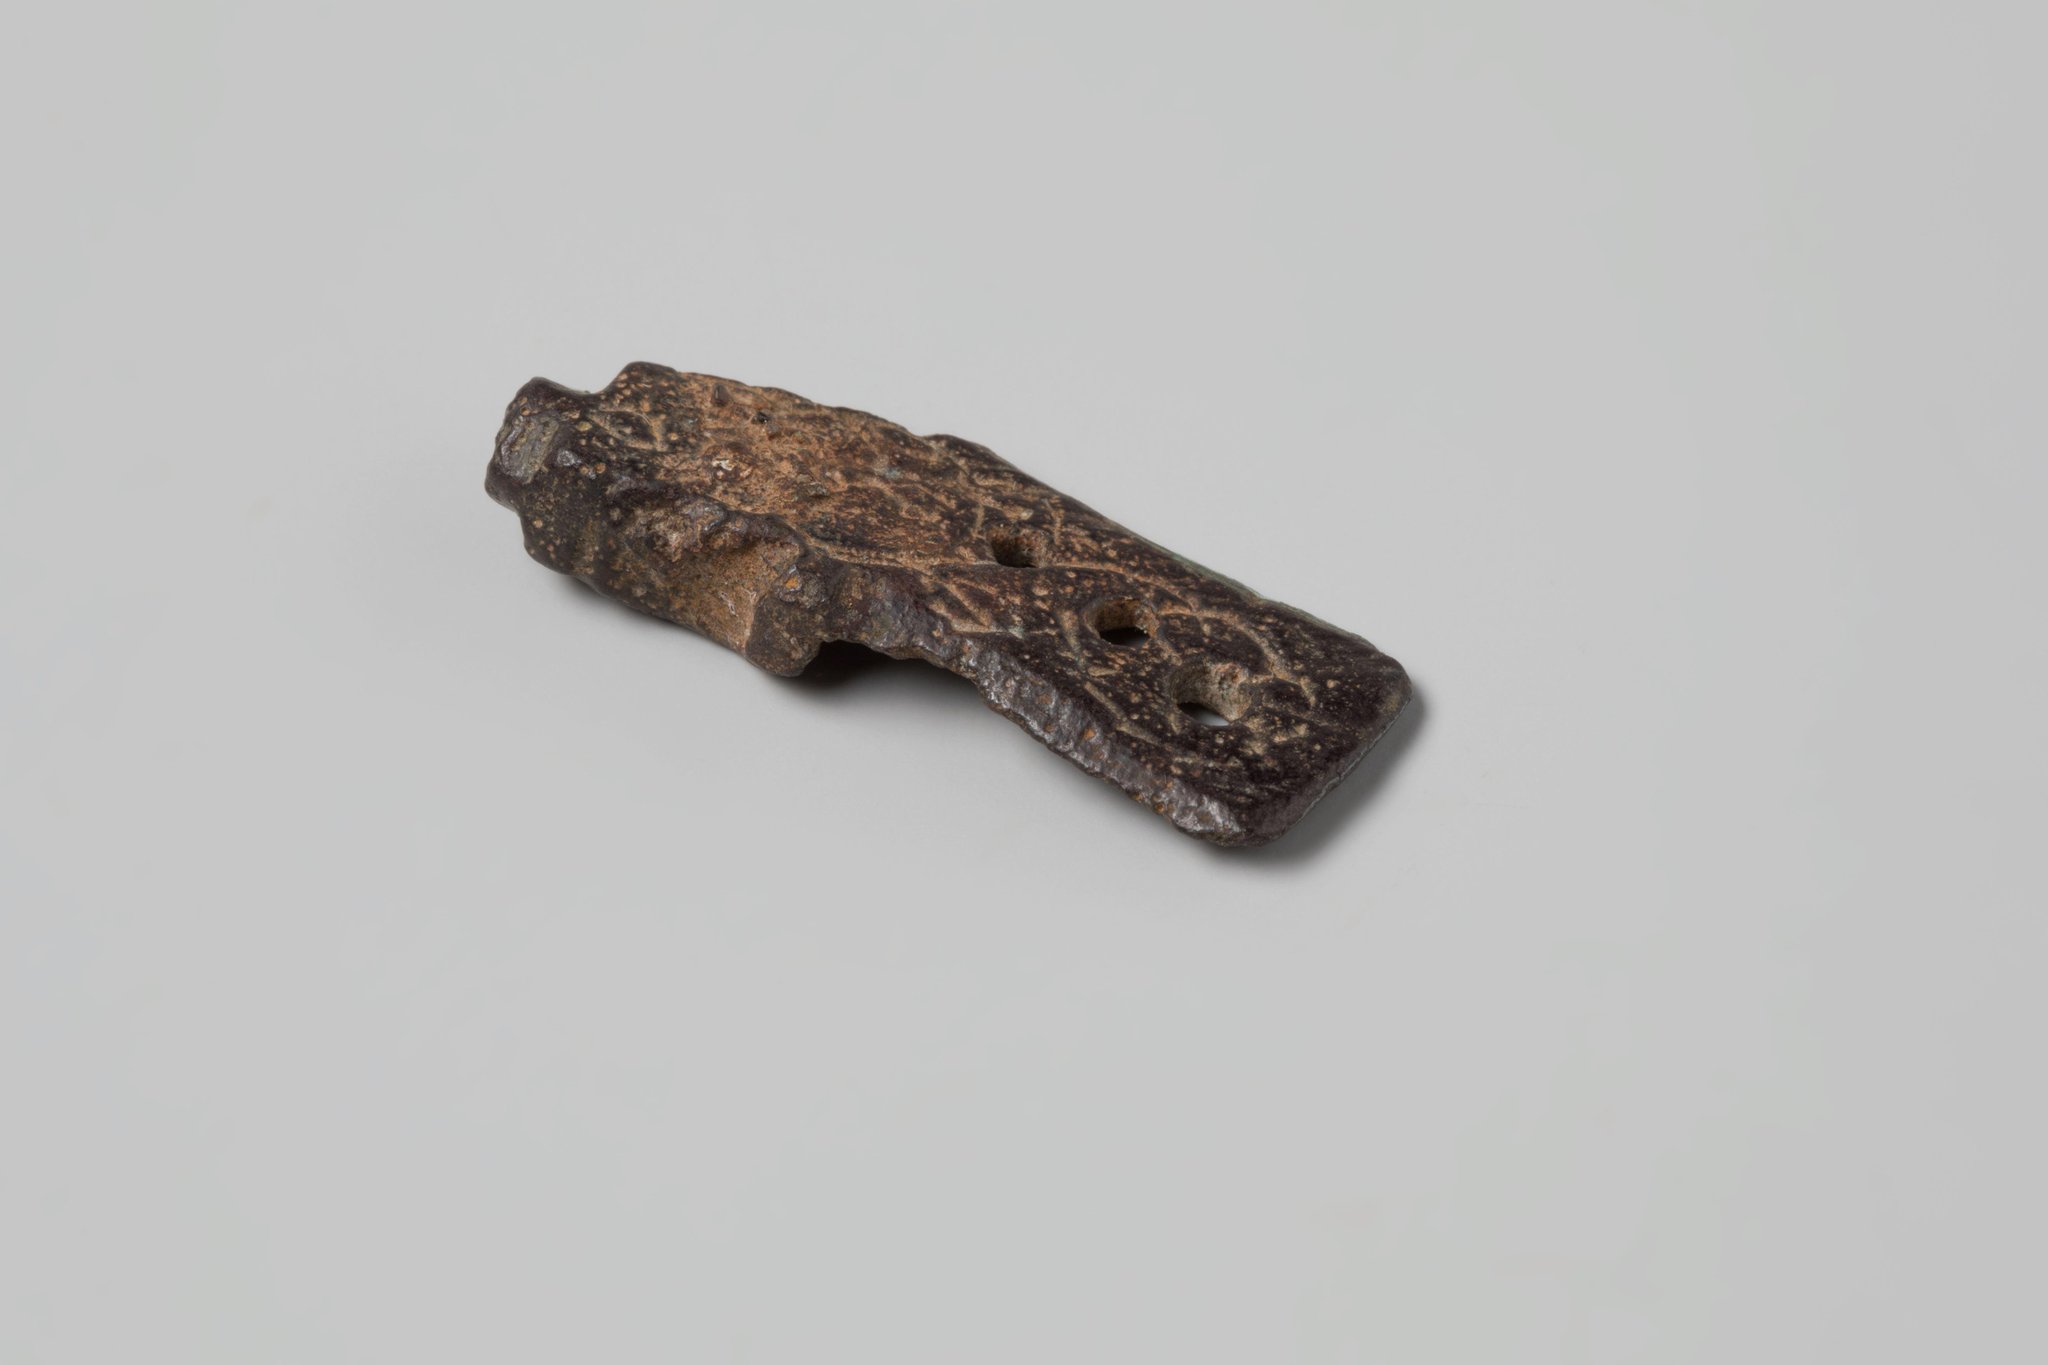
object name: pin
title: Fragment speld uit het wrak van de Oost-Indiëvaarder Hollandia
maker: Anonymous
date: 1700-1743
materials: copper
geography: netherlands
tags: verenigde oostindische compagnie, hollandia (schip), annet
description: Tools and instruments, sewing and sailmaking, pin; fragm of shaft with blade-mount, 3 rivet-holes.